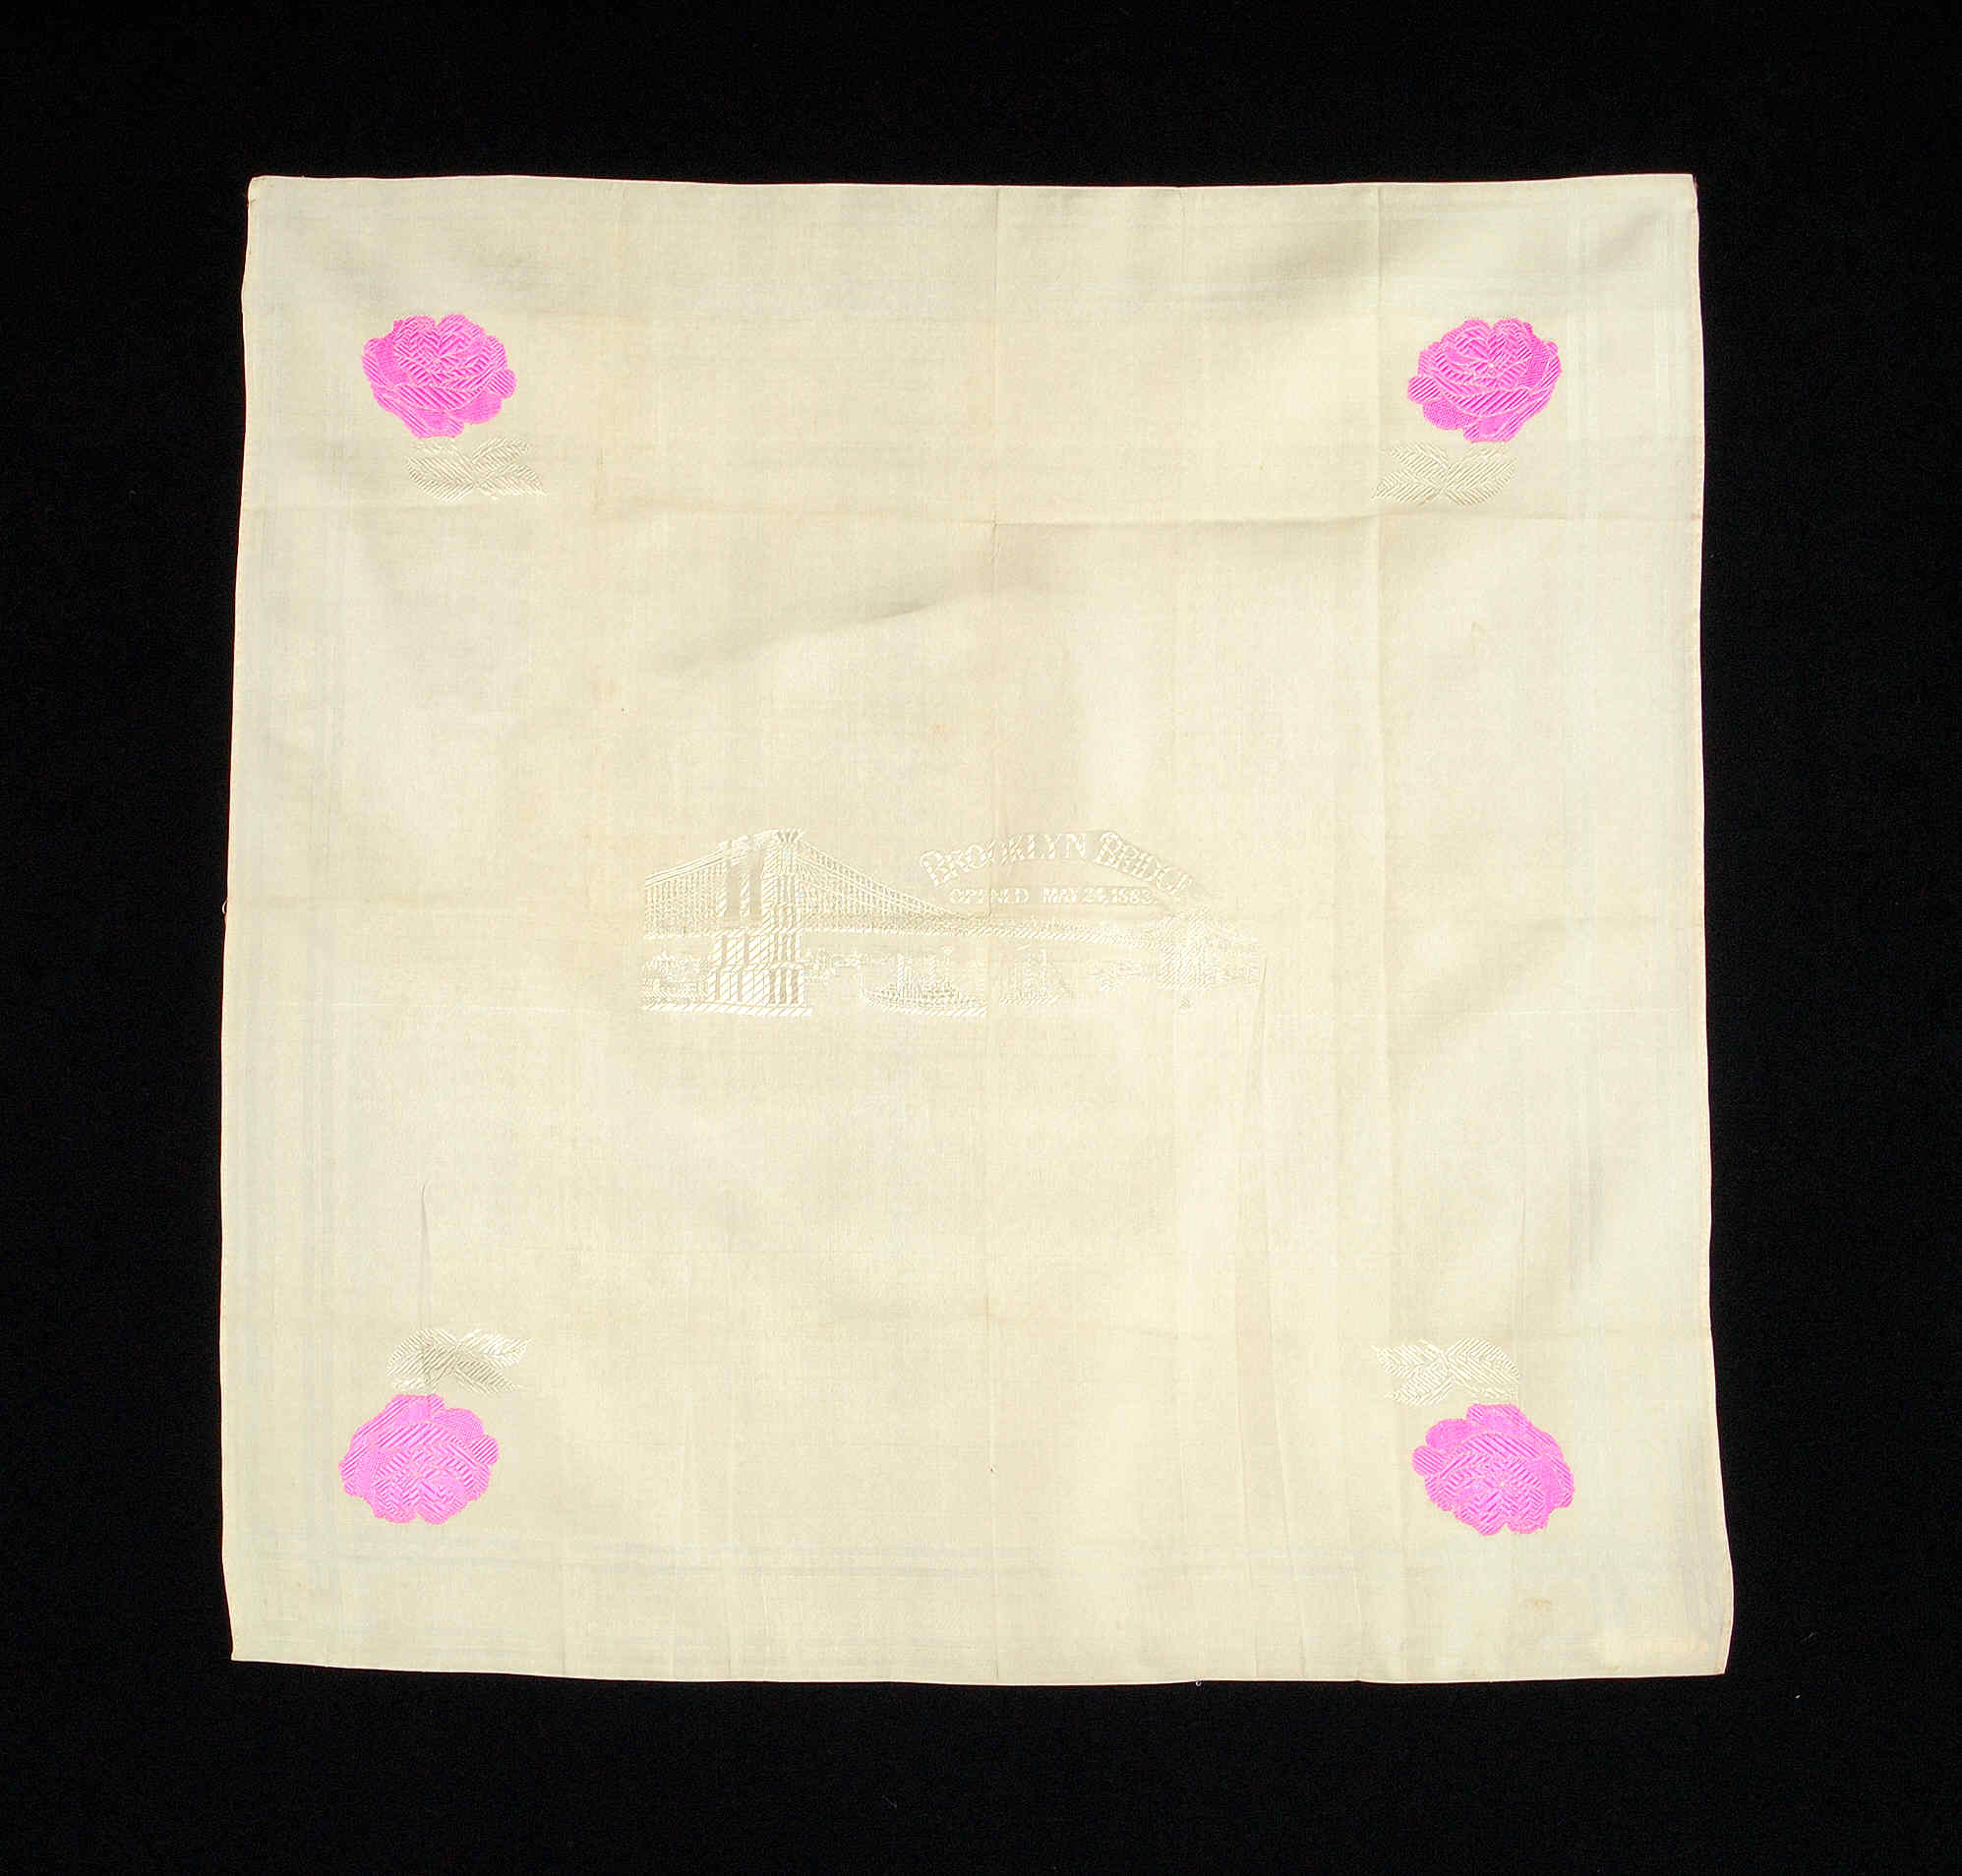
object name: handkerchief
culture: american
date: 1883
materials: silk